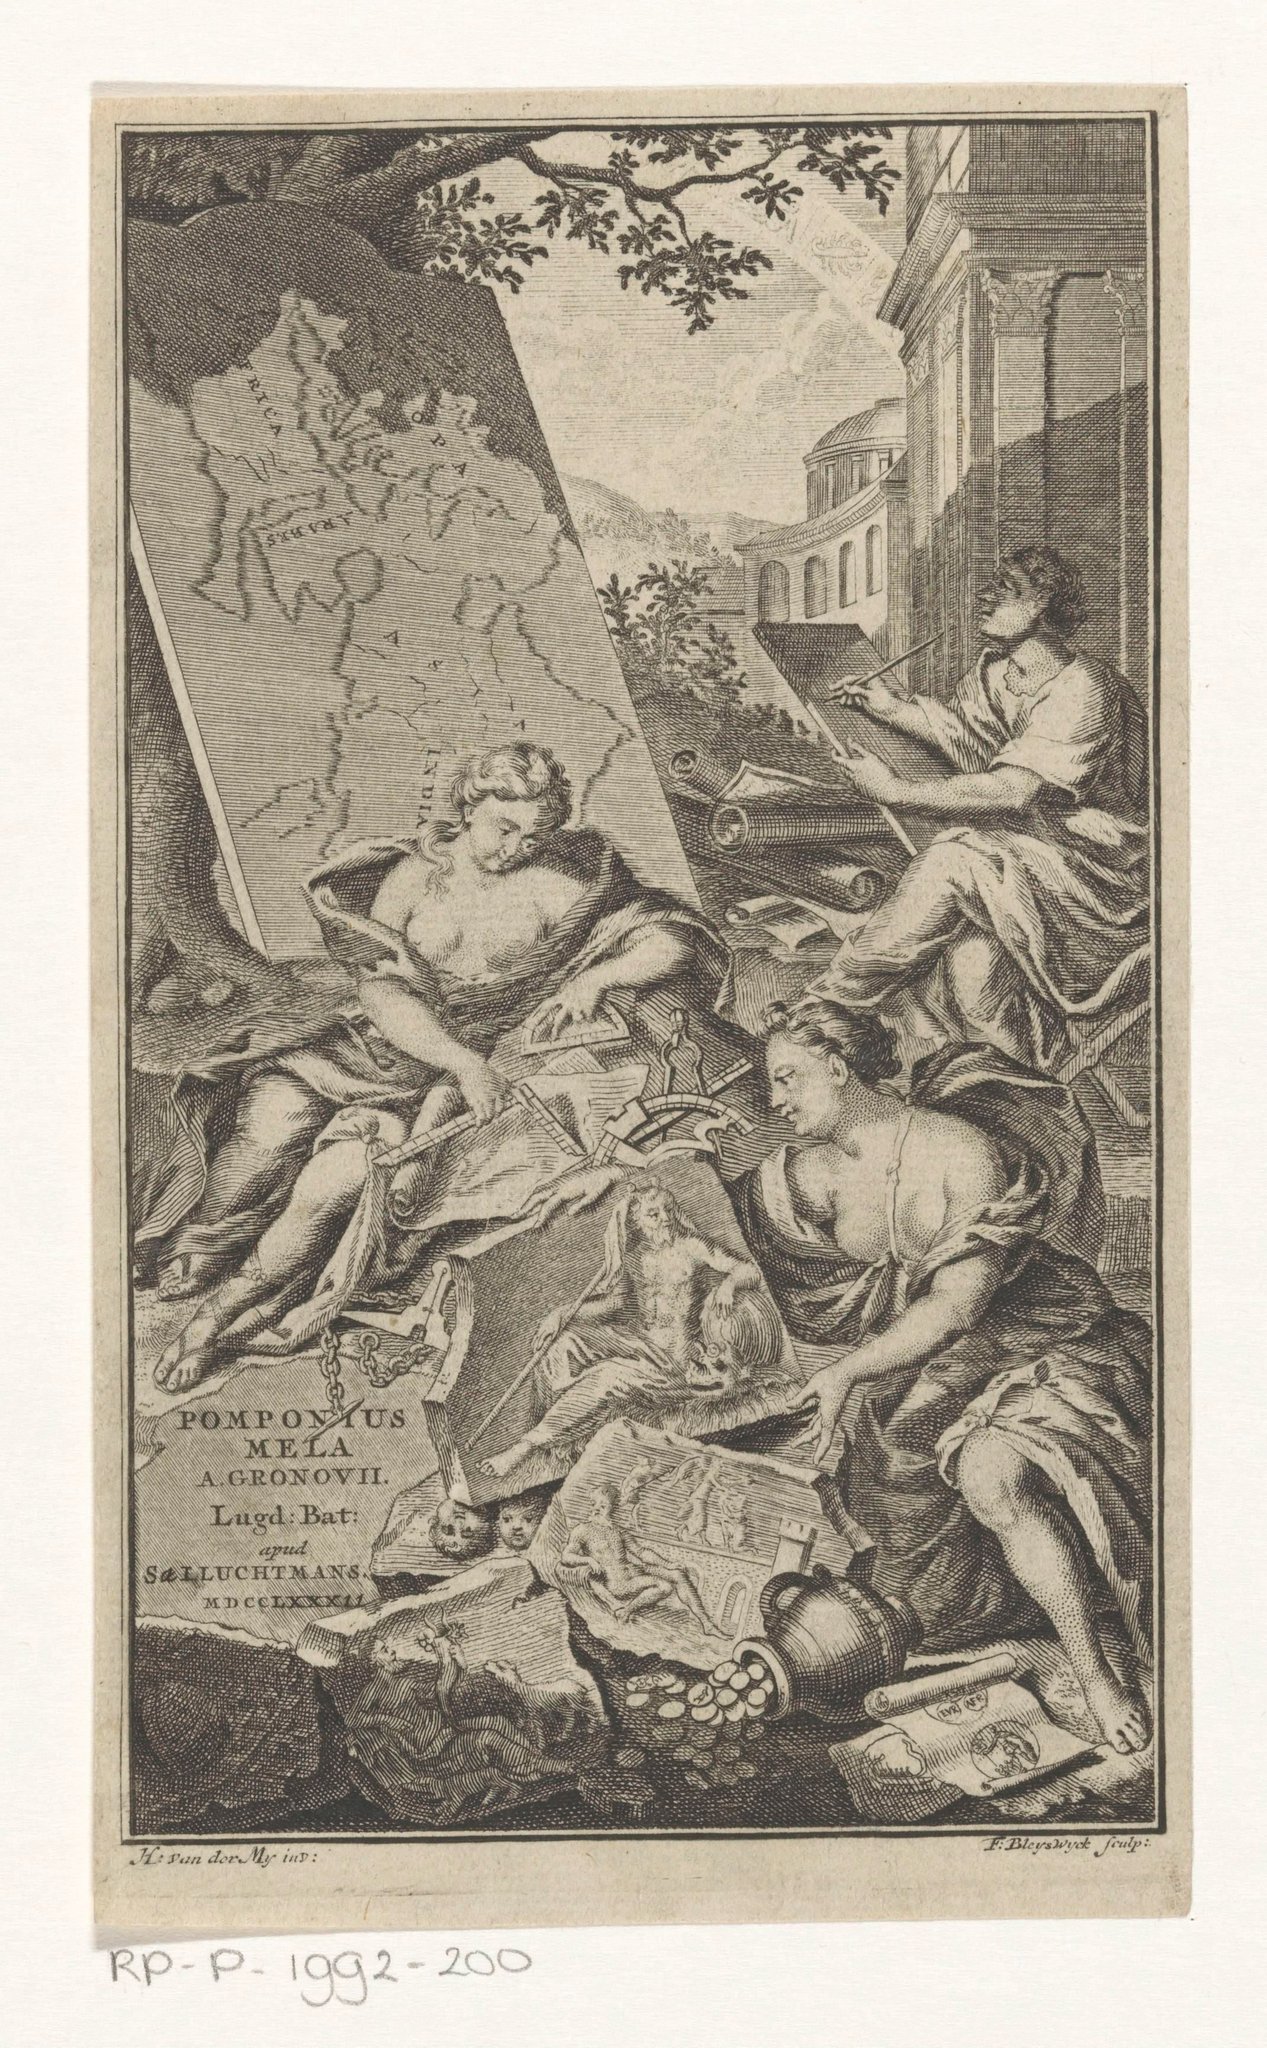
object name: print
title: Titelpagina voor: Pomponius Mela en Abraham Gronovius, Pomponii Melae de situ orbis libri III, 1782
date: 1782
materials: paper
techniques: engraving, etching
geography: leiden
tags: quadrivium (personification of arithmetica, geometria, astronomia, and musica), map of the world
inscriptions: collector's mark: Lugt 2760, collector's mark: Lugt 2228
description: Onder een kaart van de wereld zit Meetkunde, met teken- en meetinstrumenten in de handen en een plattegrond. Rechtsachter tekent een man een kaart aan de hand van de wereldkaart. Op de voorgrond zit een vrouw met brokstukken uit de klassieke oudheid.